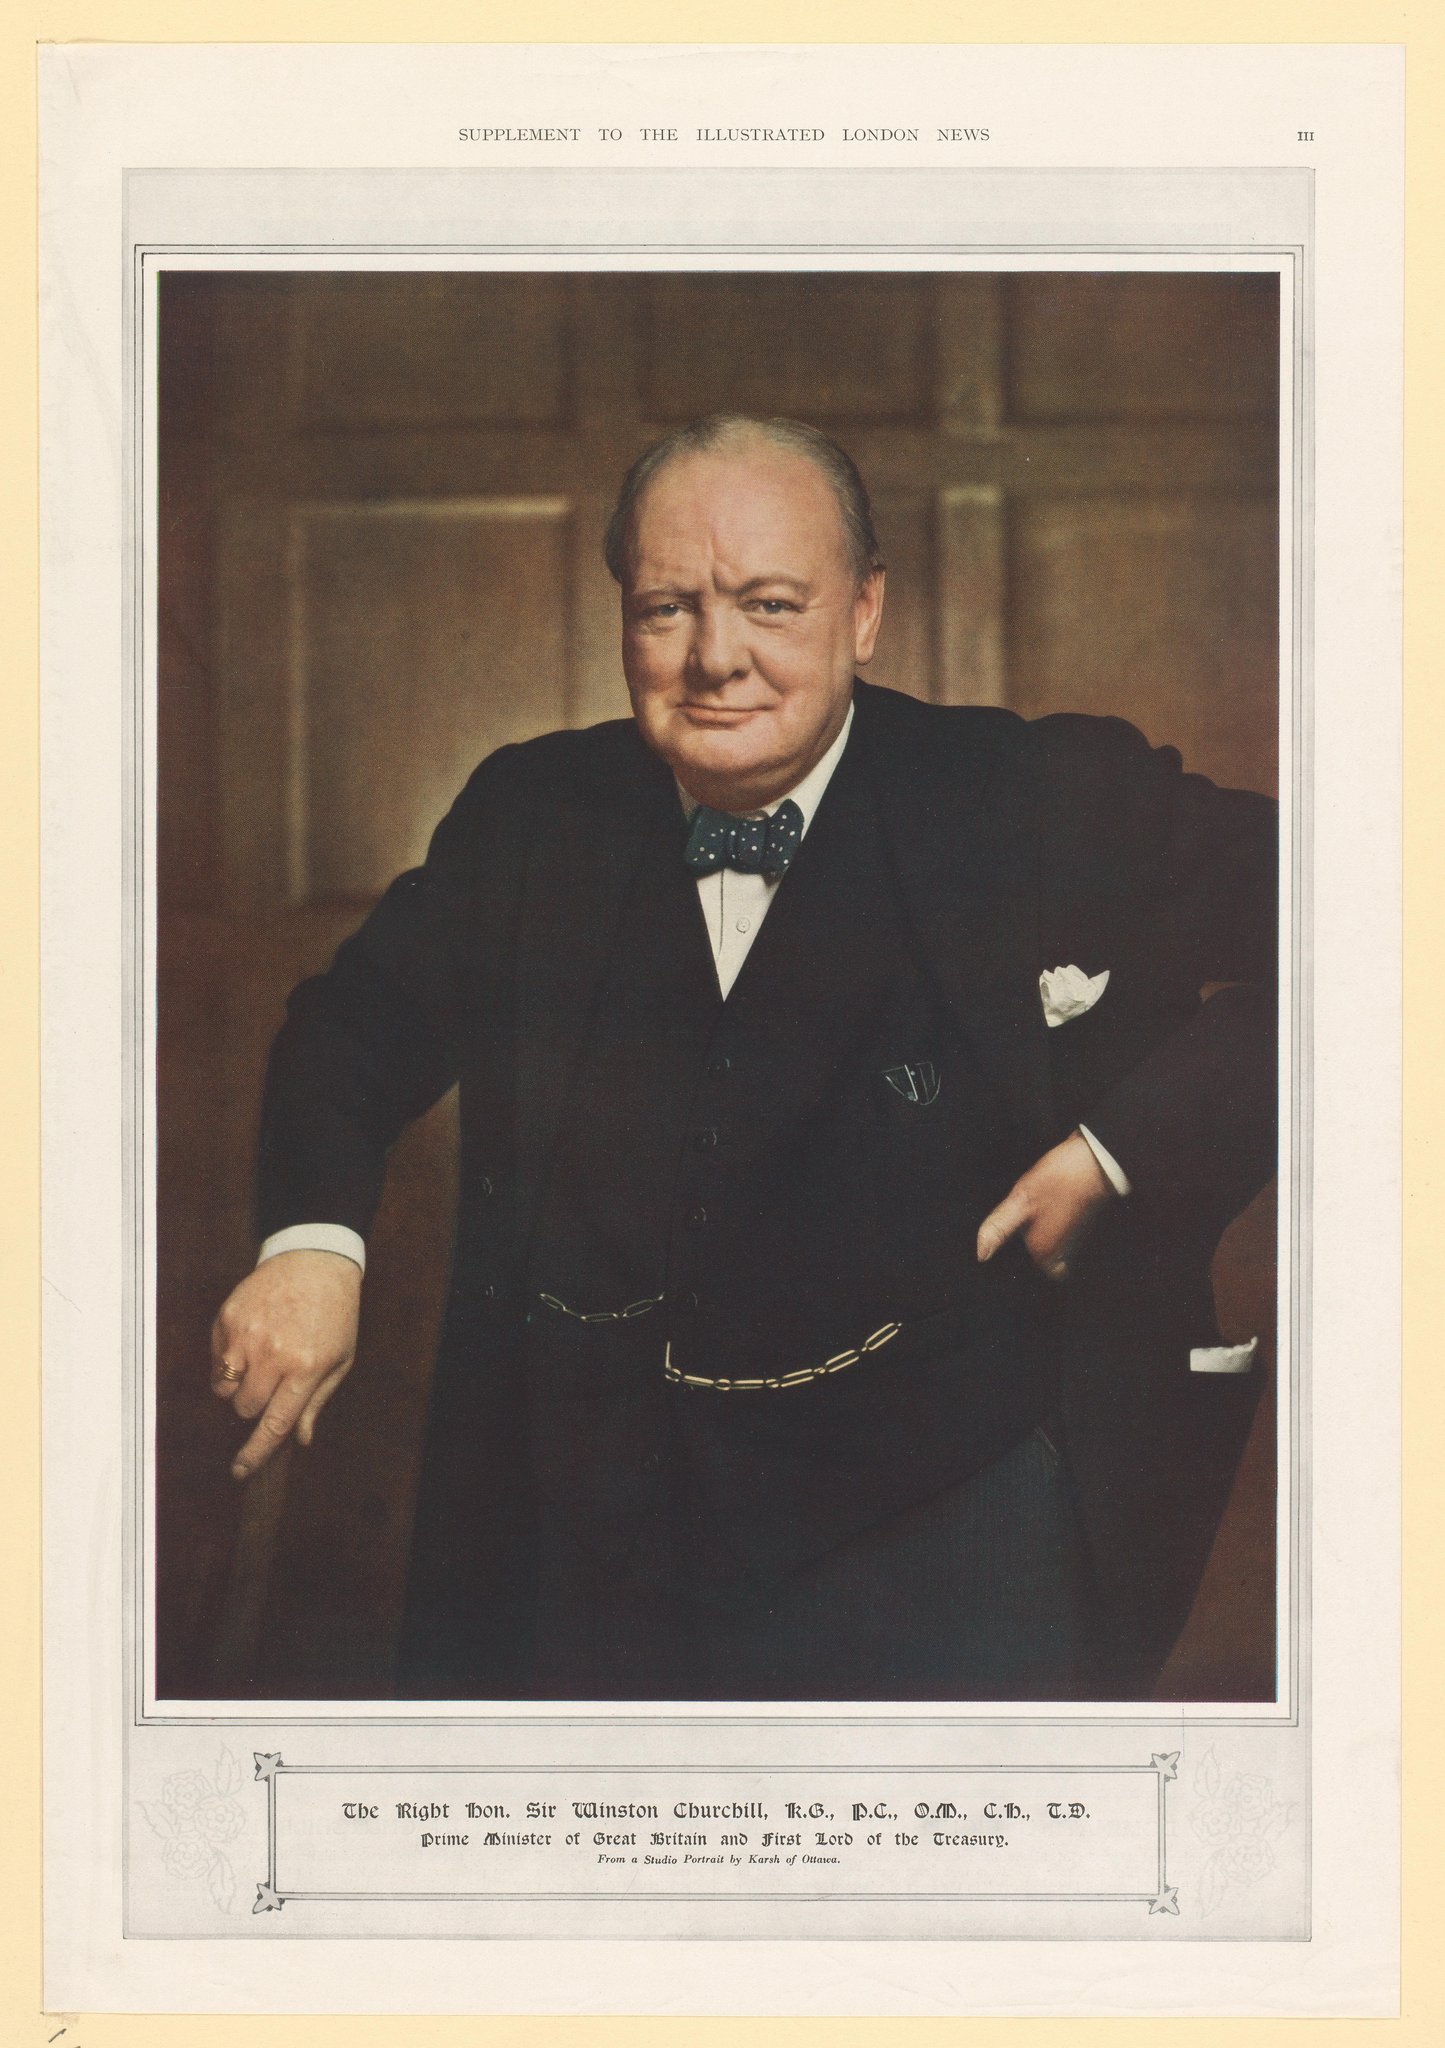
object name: photomechanical print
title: The Right hon. Sir Winston Churchill, k.G., D.C., C.H., T.D Prime Minister of Great Britain and First Lord of the Treasury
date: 1941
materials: paper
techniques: four-color autotype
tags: historical persons, politician, e.g. party leader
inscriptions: inscription: ‘SUPLLEMENT TO THE ILLUSTRATED LONDON NEWS’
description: Fotomechanisch portret van Winston Churchill, afkomstig uit de Illustrated London News.